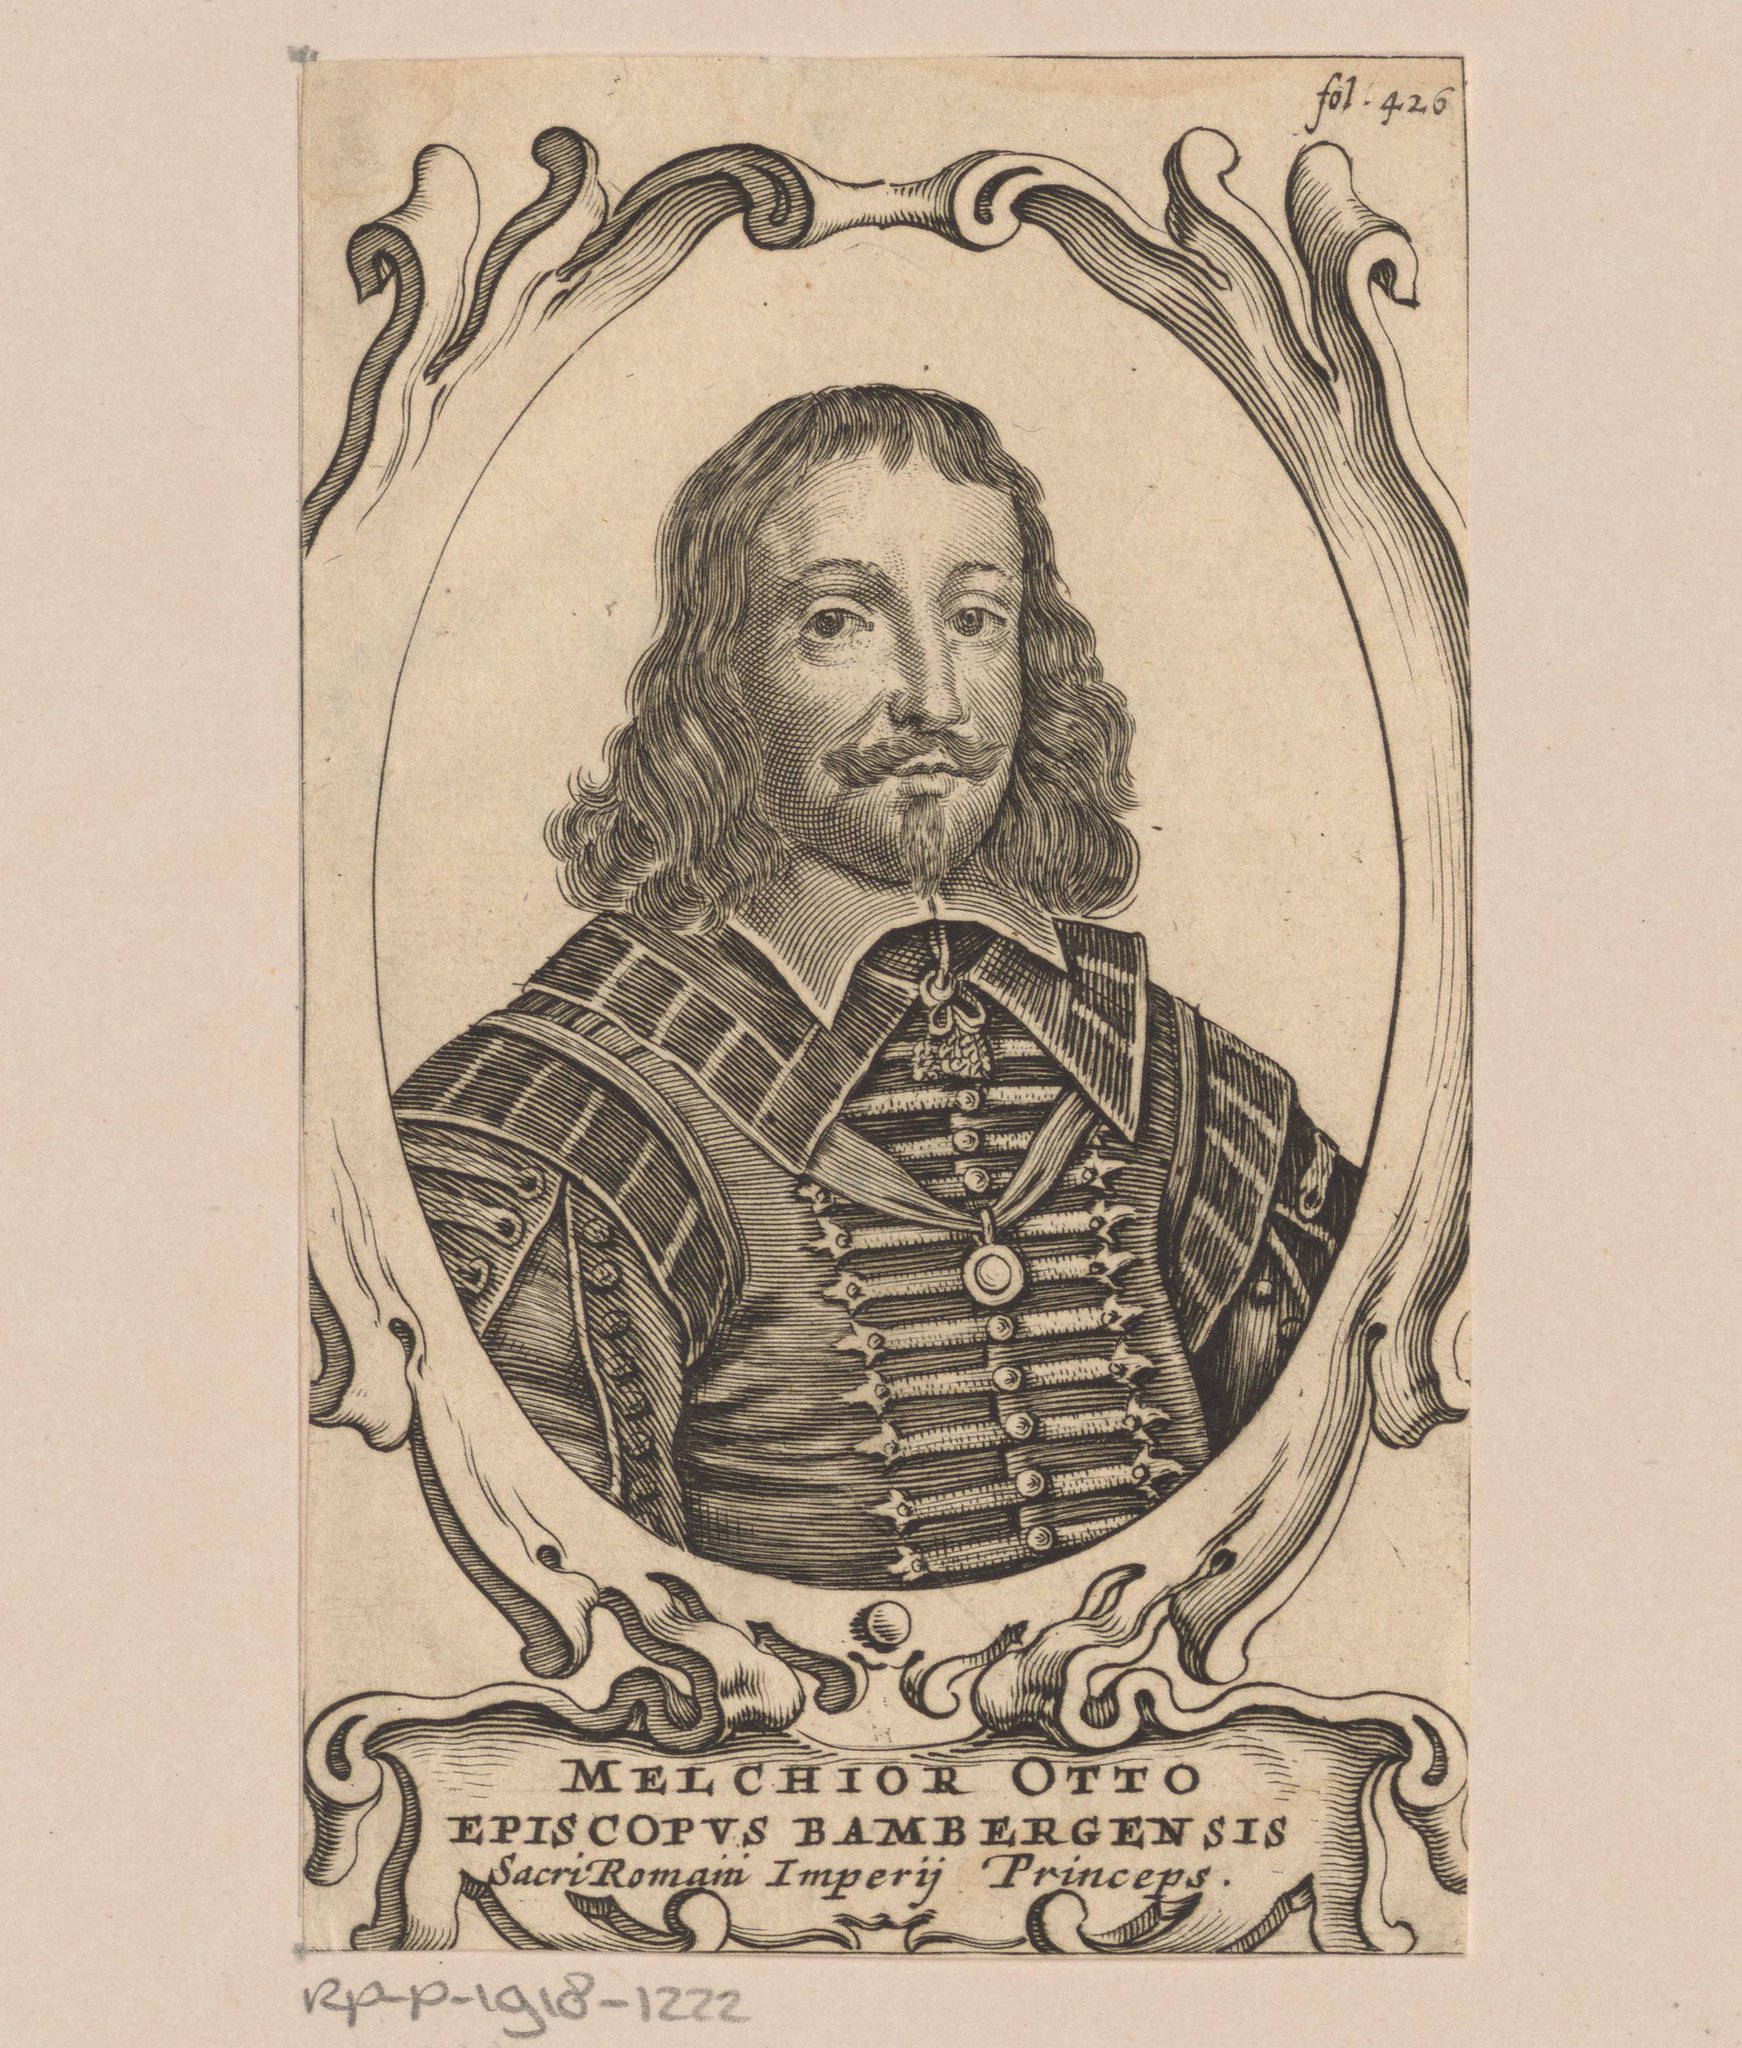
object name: print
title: Portret van Melchior Otto Voit von Salzburg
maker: Anonymous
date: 1656-1666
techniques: printmaking, engraving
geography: northern netherlands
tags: archbishop, bishop, etc. (roman catholic), historical persons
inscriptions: collector's mark: Lugt 2233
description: Prent waarschijnlijk uit: Brachelius, Johannes Adolphus. Historia nostri temporis, dat is: geschiedenis onses tijdts, (...). Rotterdam: Andries van Hoogenhuyse, 1656. Prent ook gebruikt in de edities uit 1659 en 1666.